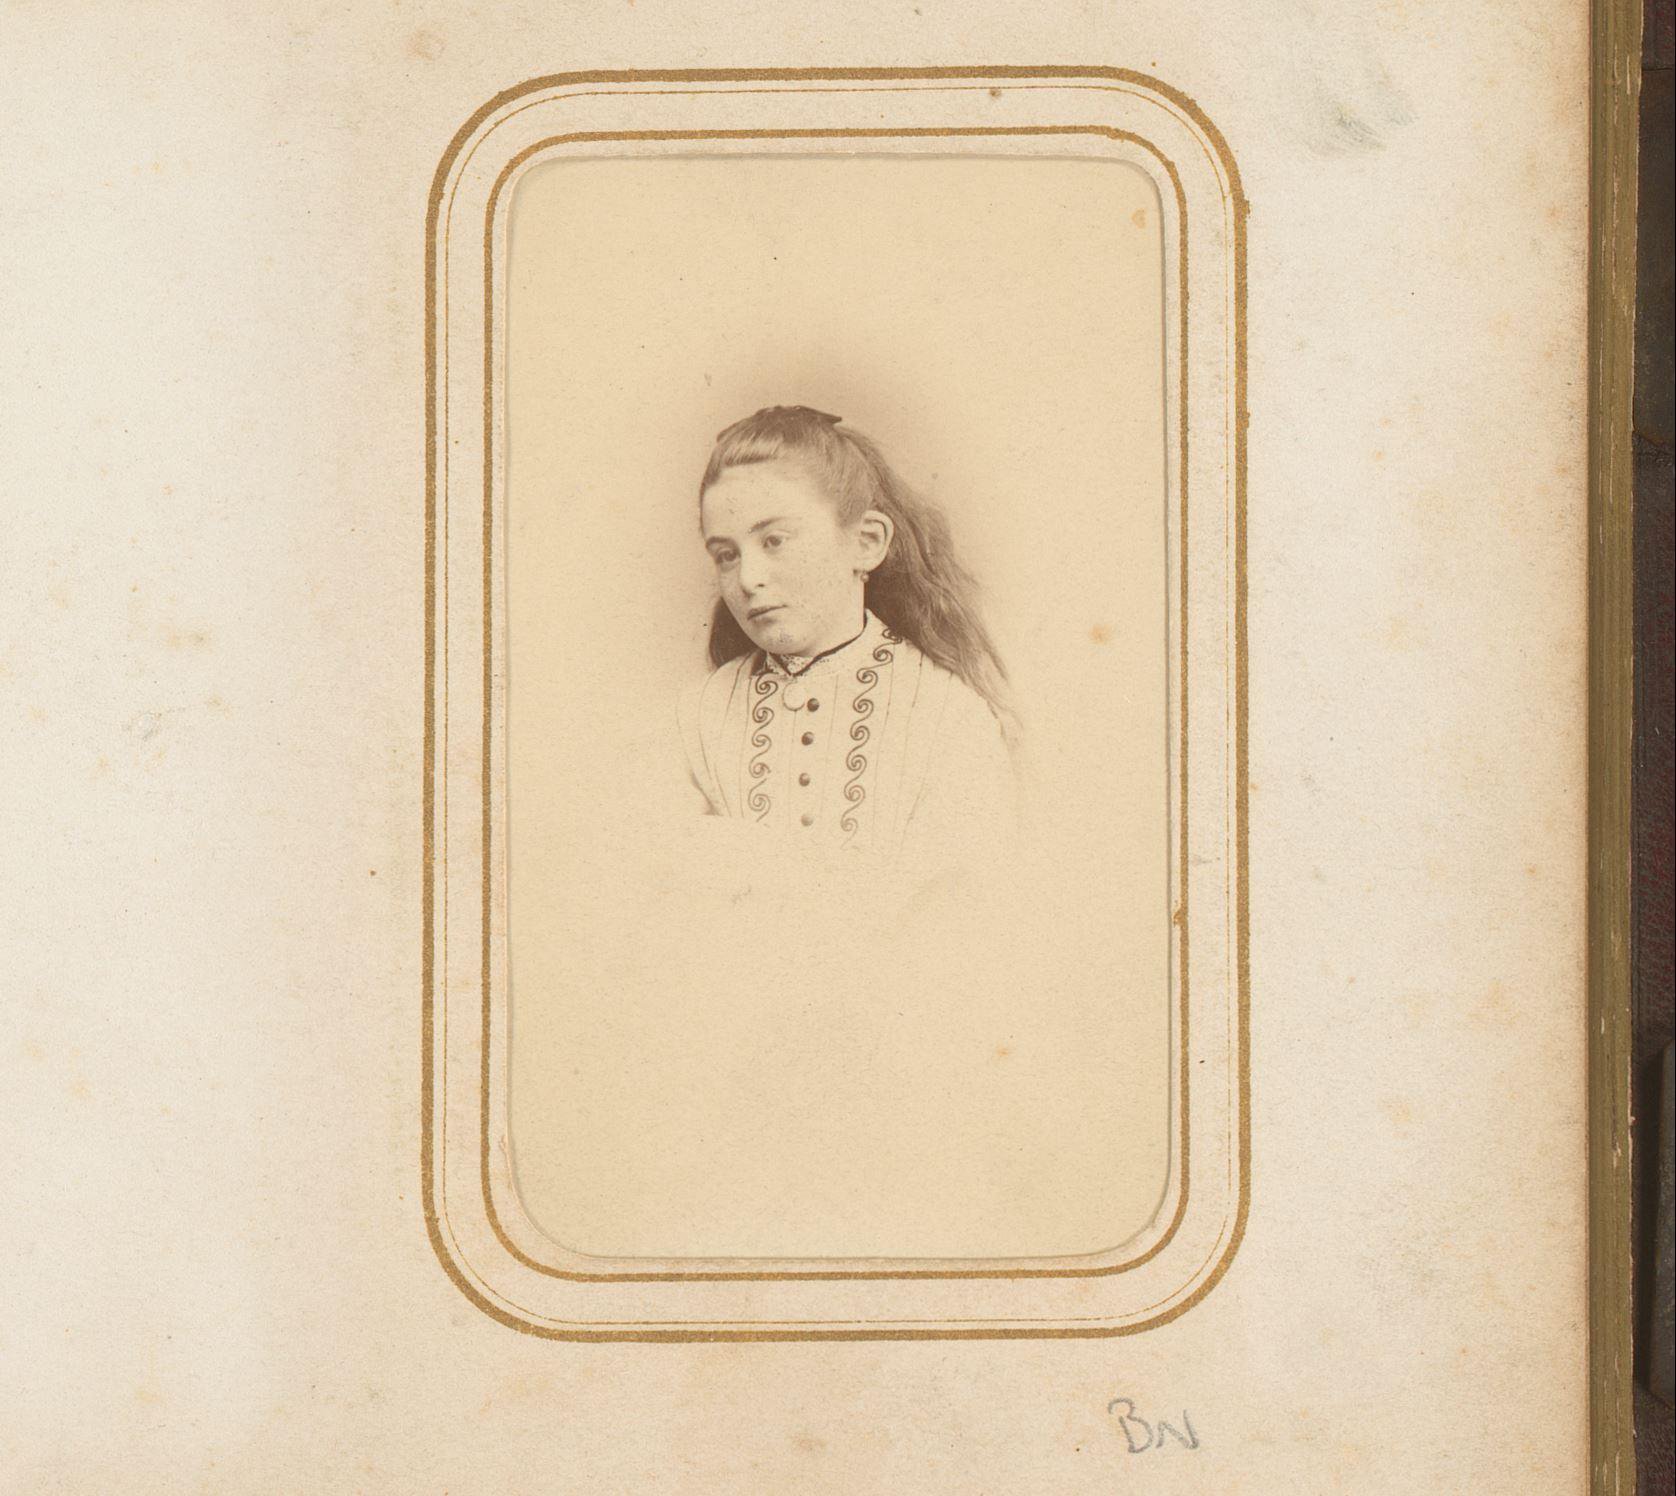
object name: album leaf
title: Portret van een meisje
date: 1865-1900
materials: cardboard, photographic support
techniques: albumen print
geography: netherlands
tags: historical persons - bb - woman, girl (child between toddler and youth)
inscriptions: inscription: ‘Photogr. Atelier/ Wegner & Mottu/ Kalverstraat/ over den Heyligenweg D.26/ Amsterdam/ Leydsche Straatweg/ Buiten Cathrynen/ Utrecht’, annotation: ‘Posant - bien/ causant - bien/ agissant mal’